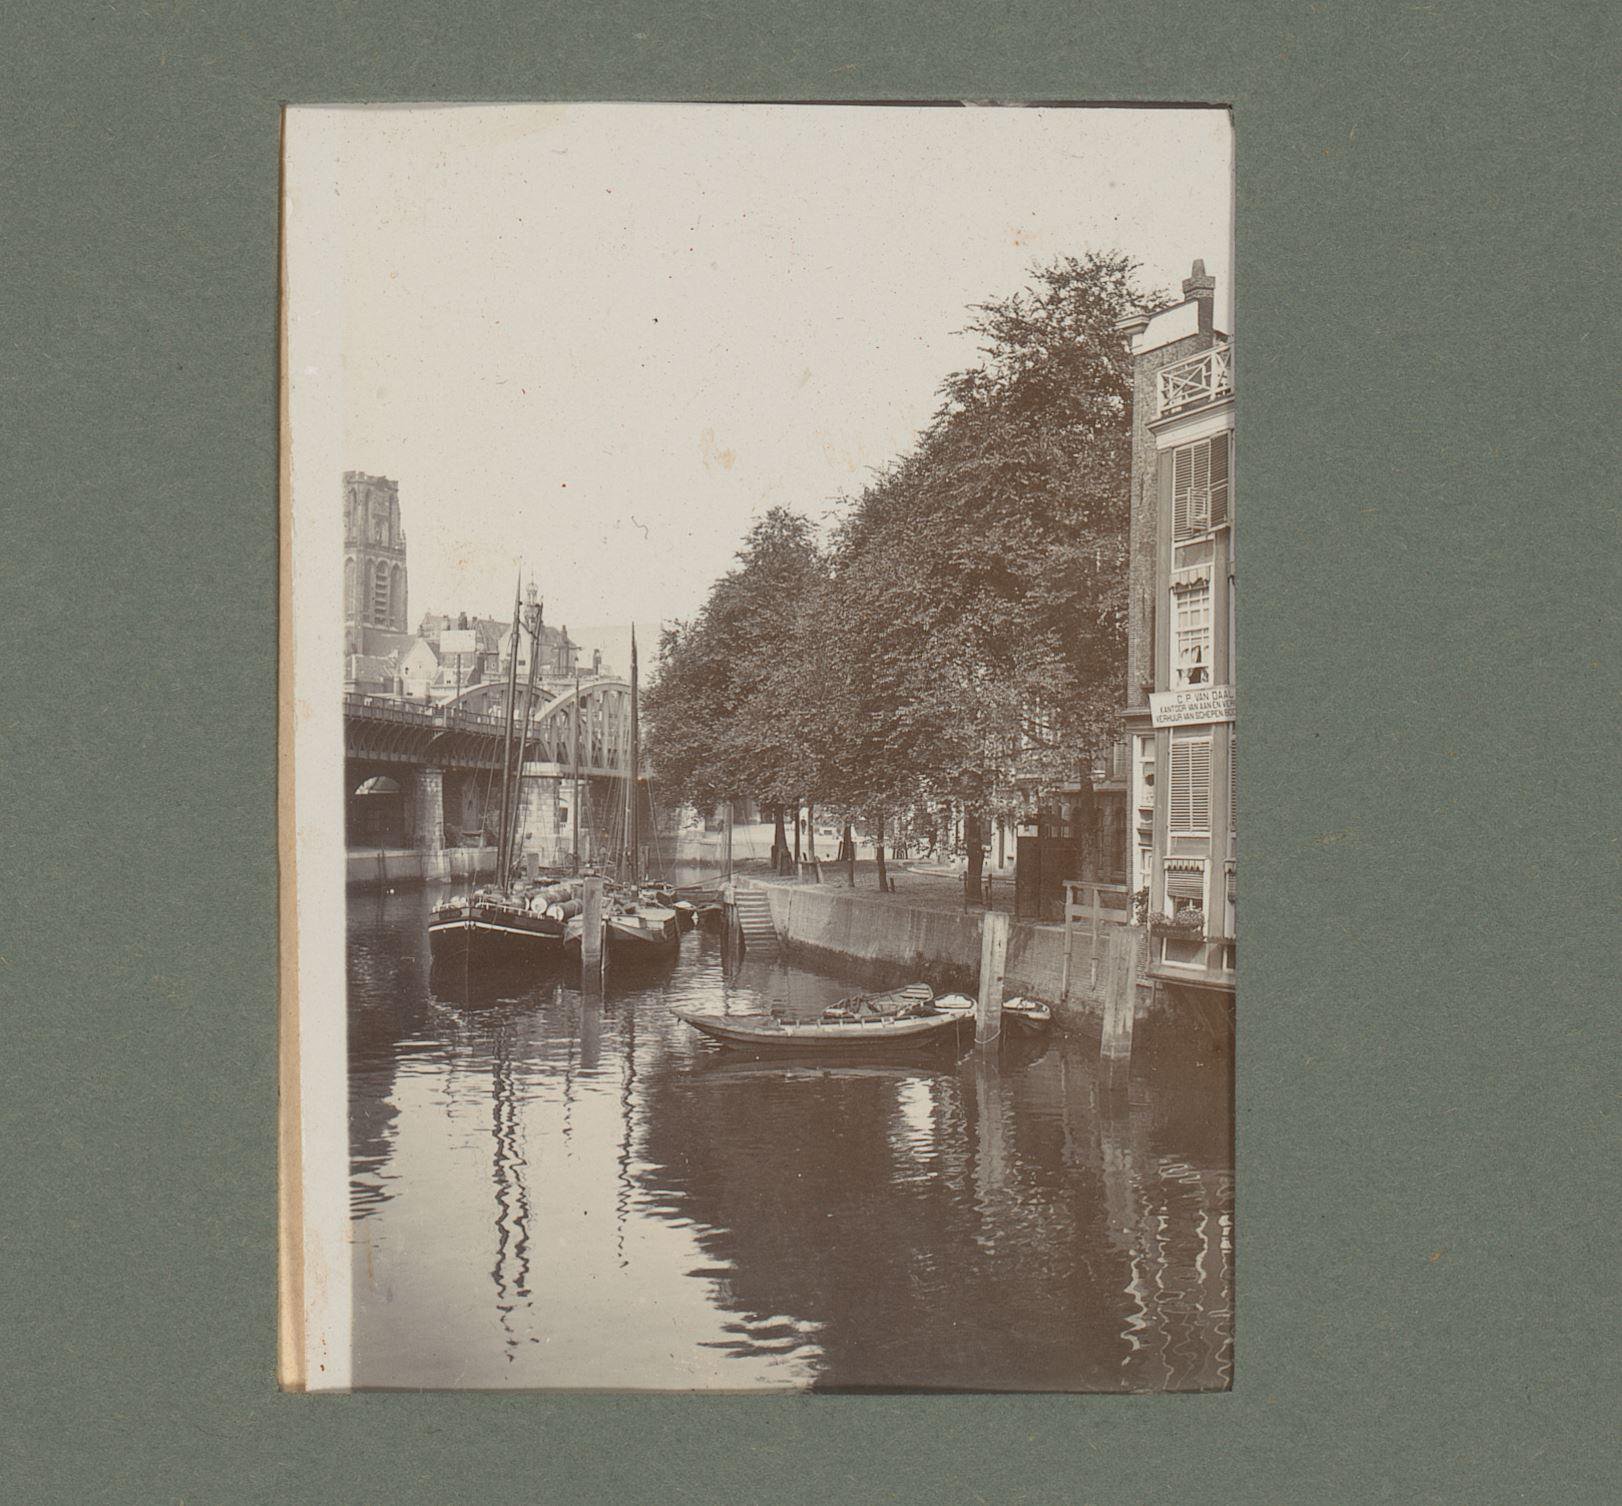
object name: photograph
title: Gezicht op de Toerijstuin richting de Binnenrotte te Rotterdam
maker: george hidderley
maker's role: fotograaf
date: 1900-1920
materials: photographic support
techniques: gelatin silver print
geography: rotterdam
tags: bailey bridge, canals, waters (in city), parts of church exterior and annexes: tower